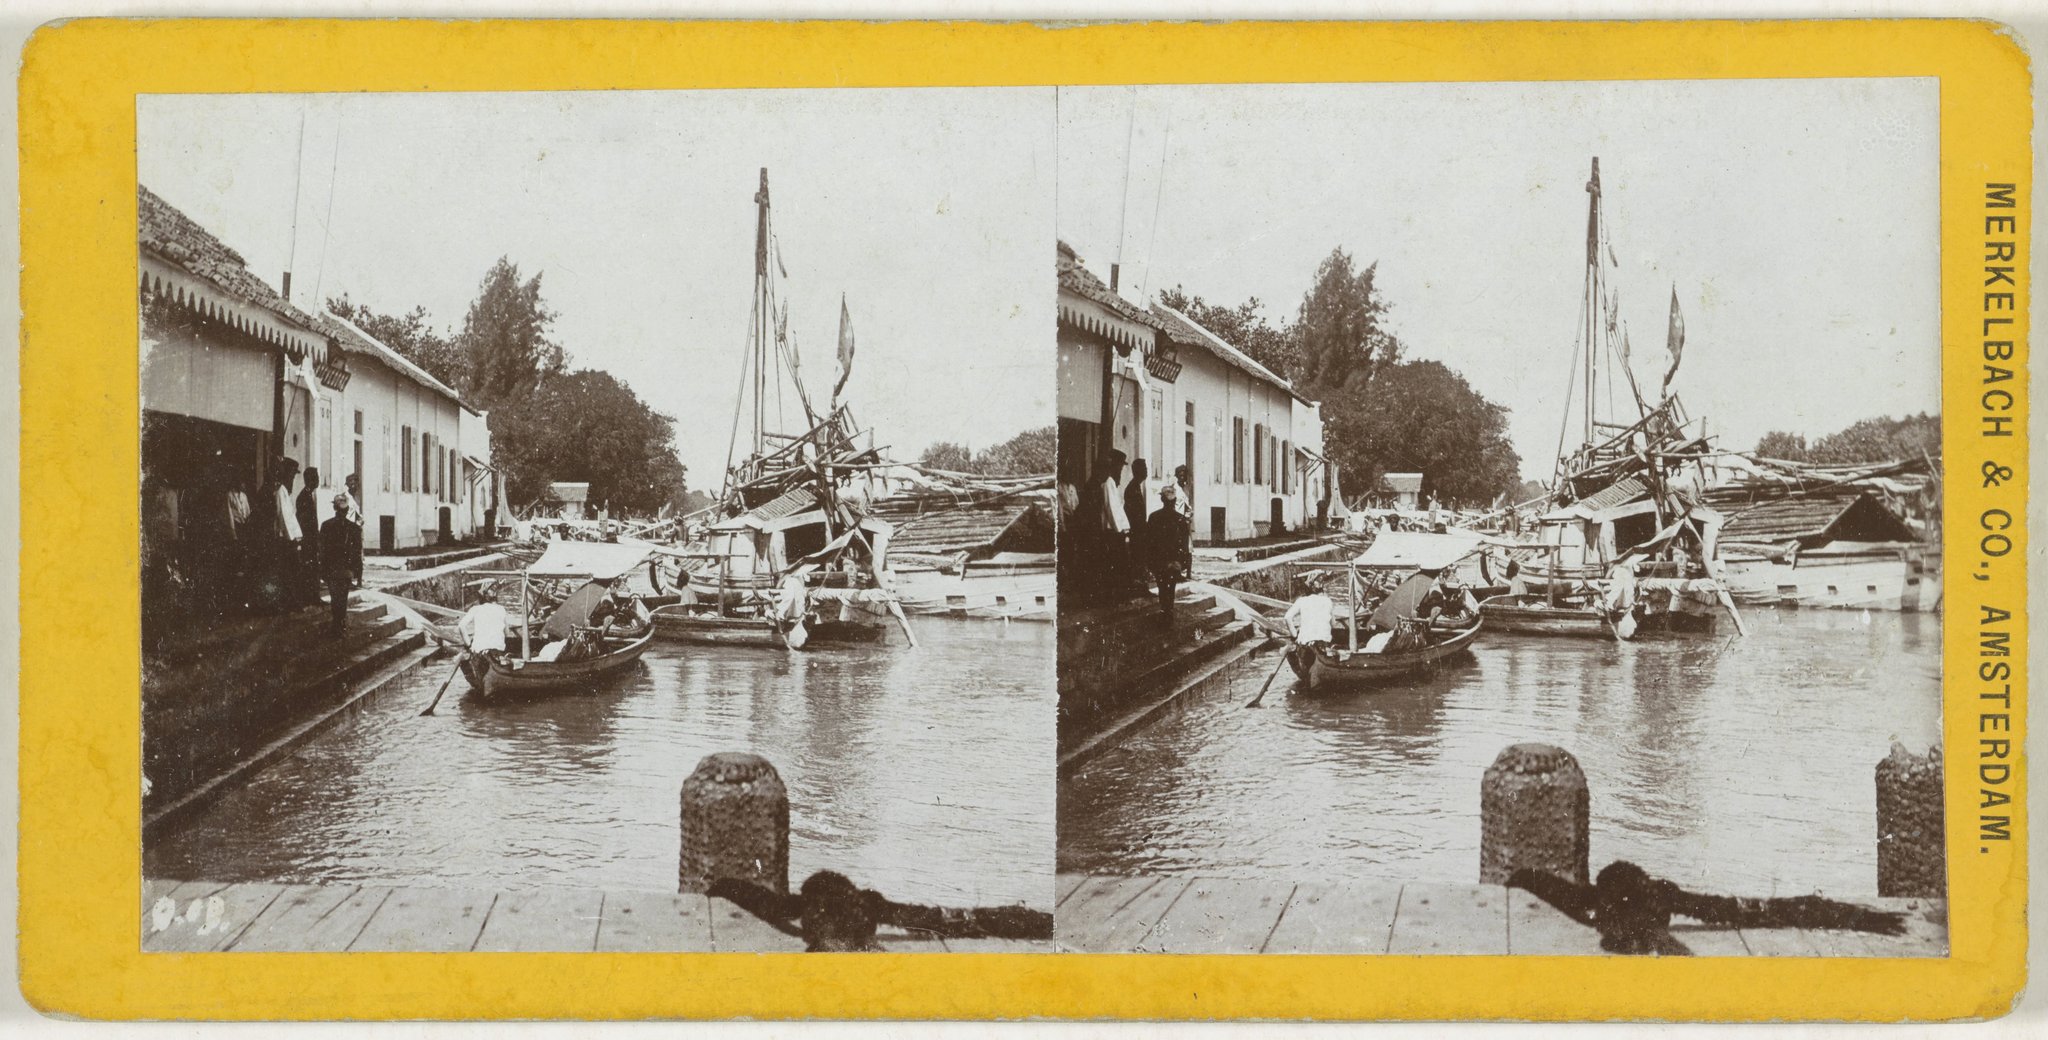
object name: stereograph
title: Aardrijkskundige beeldengalerij, verzameld door M.J. Broekhuijsen, hoofd eener school te Amsterdam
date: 1900-1902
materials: paper, cardboard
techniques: collodion silver print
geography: amsterdam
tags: harbour, toll gate, surabaya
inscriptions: number: ‘D.19.’, inscription: ‘De Boom is de aanlegplaats voor kleine vaartuigen (als prauwen) die van de groote booten aan het tolkantoor komen, (...)’